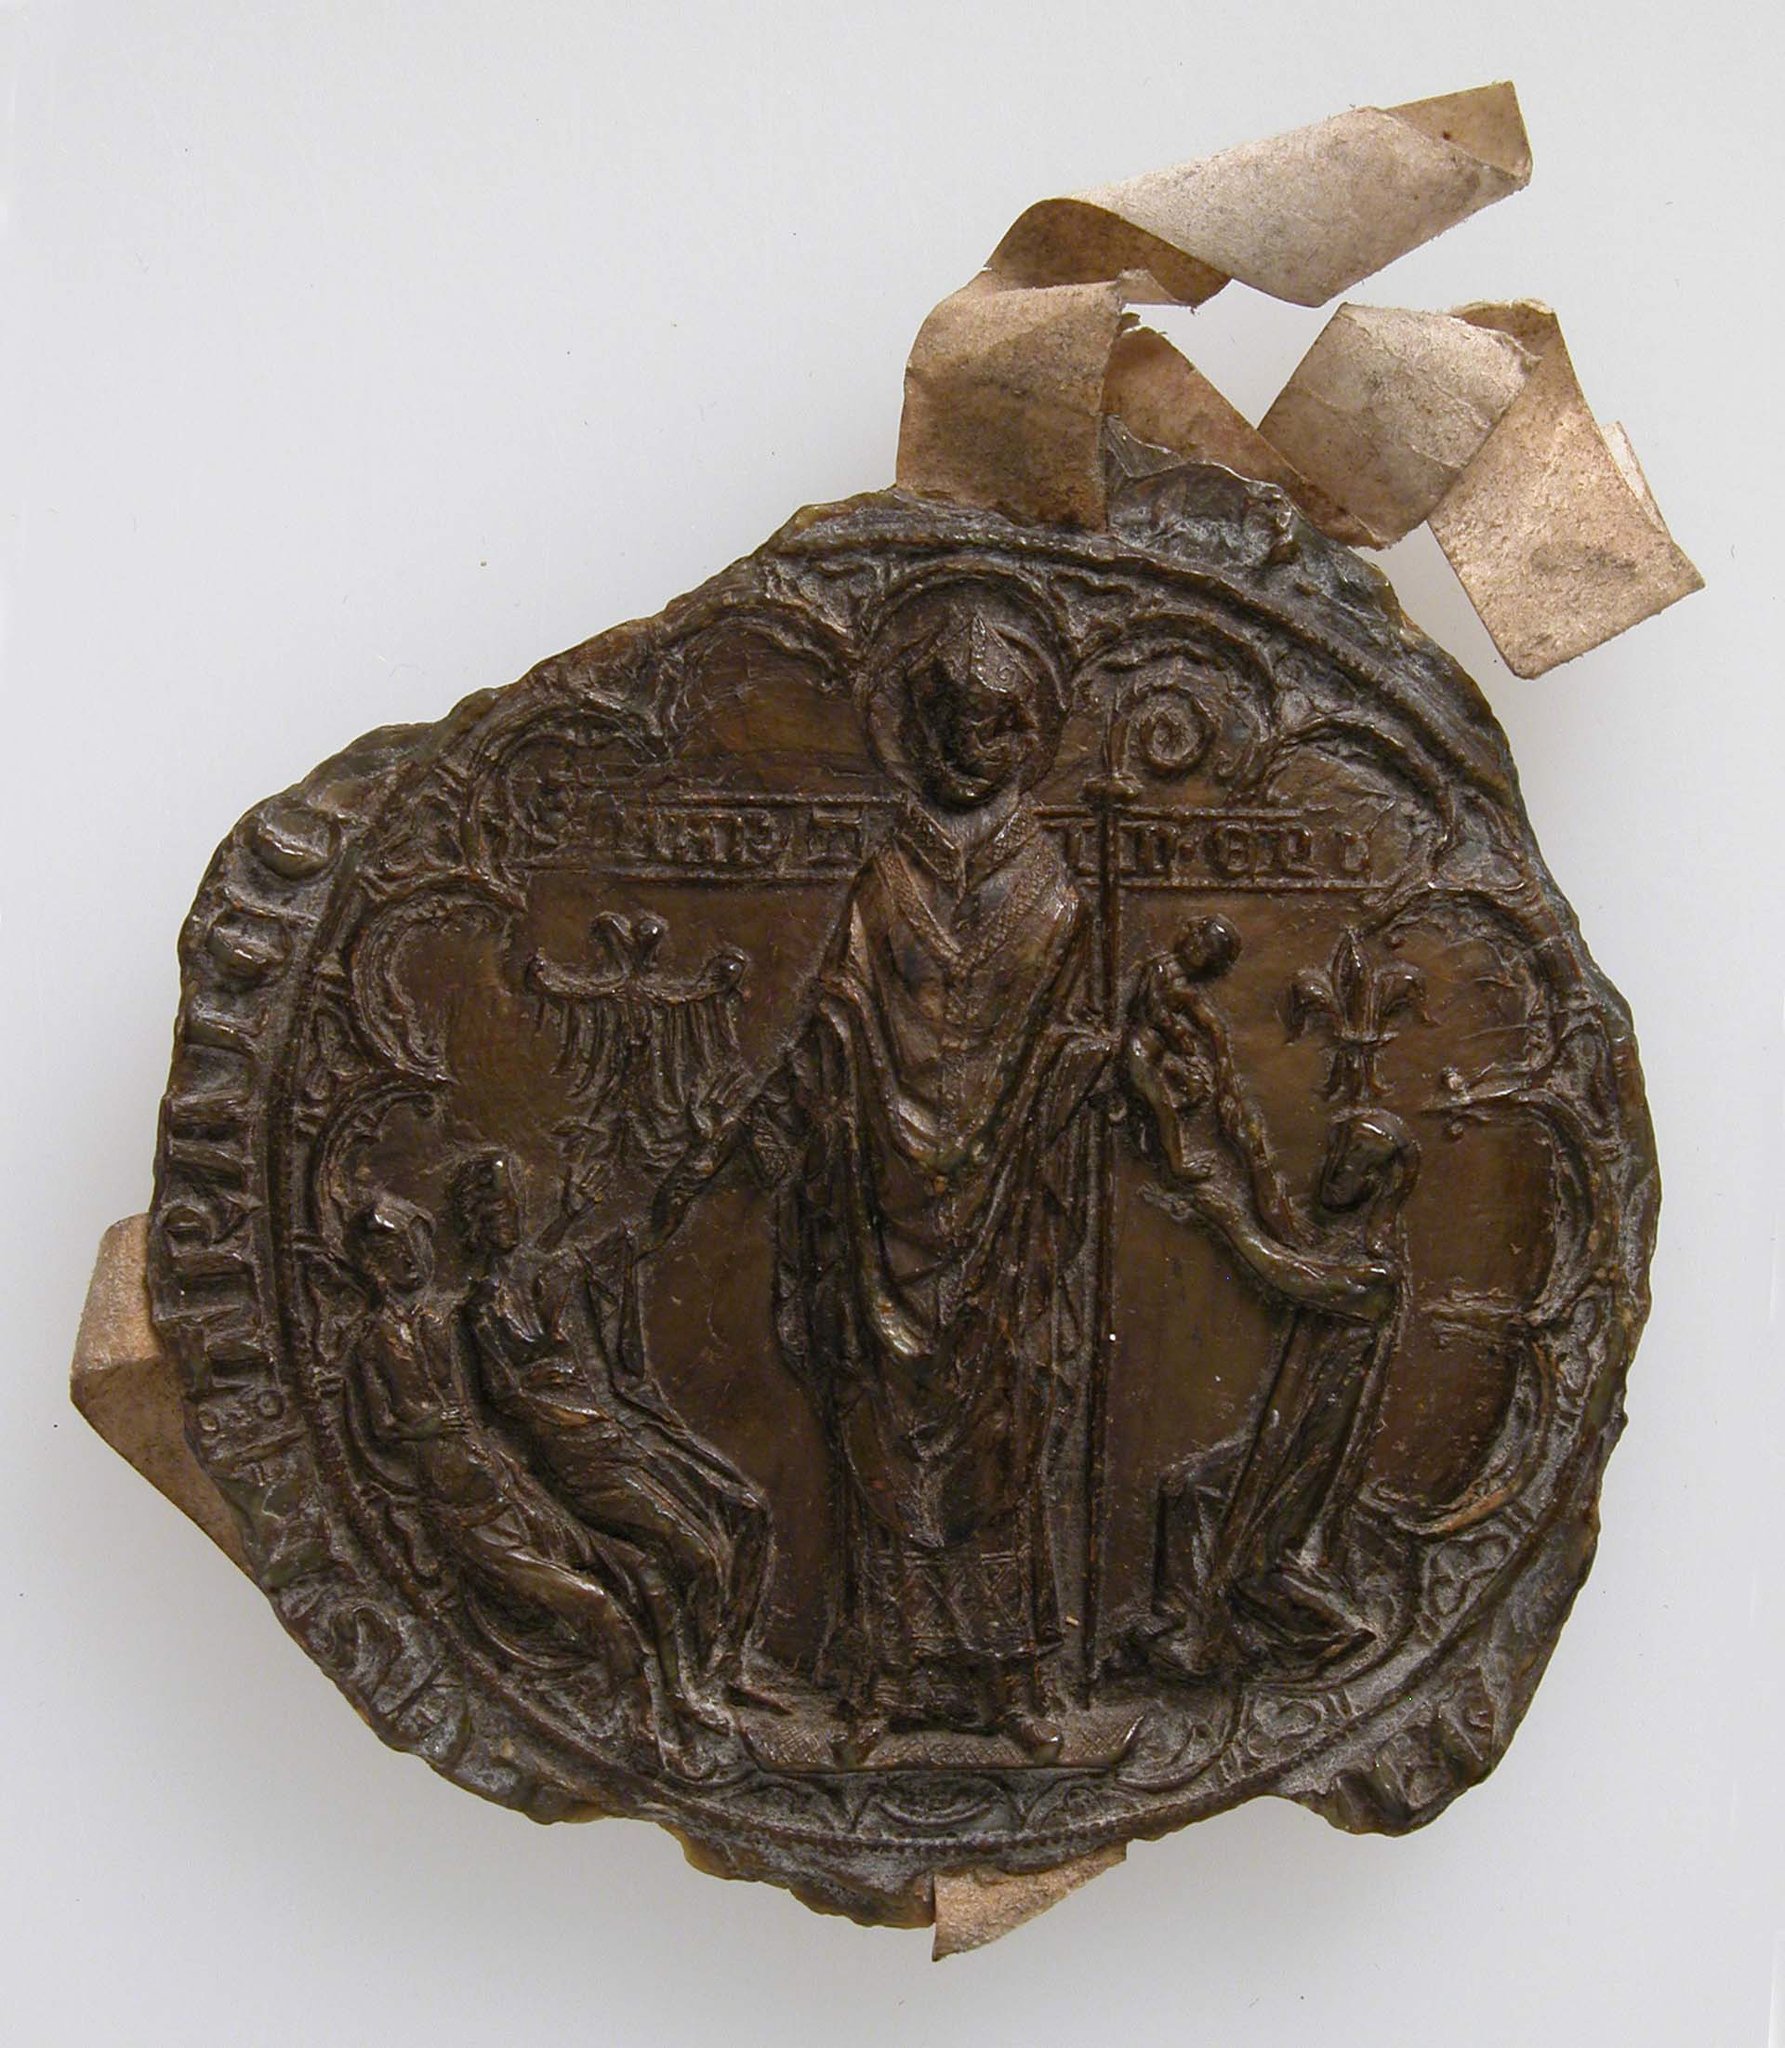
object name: seal impression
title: Seal Impression, Bishop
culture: dutch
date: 1301-1400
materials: wax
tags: bishops